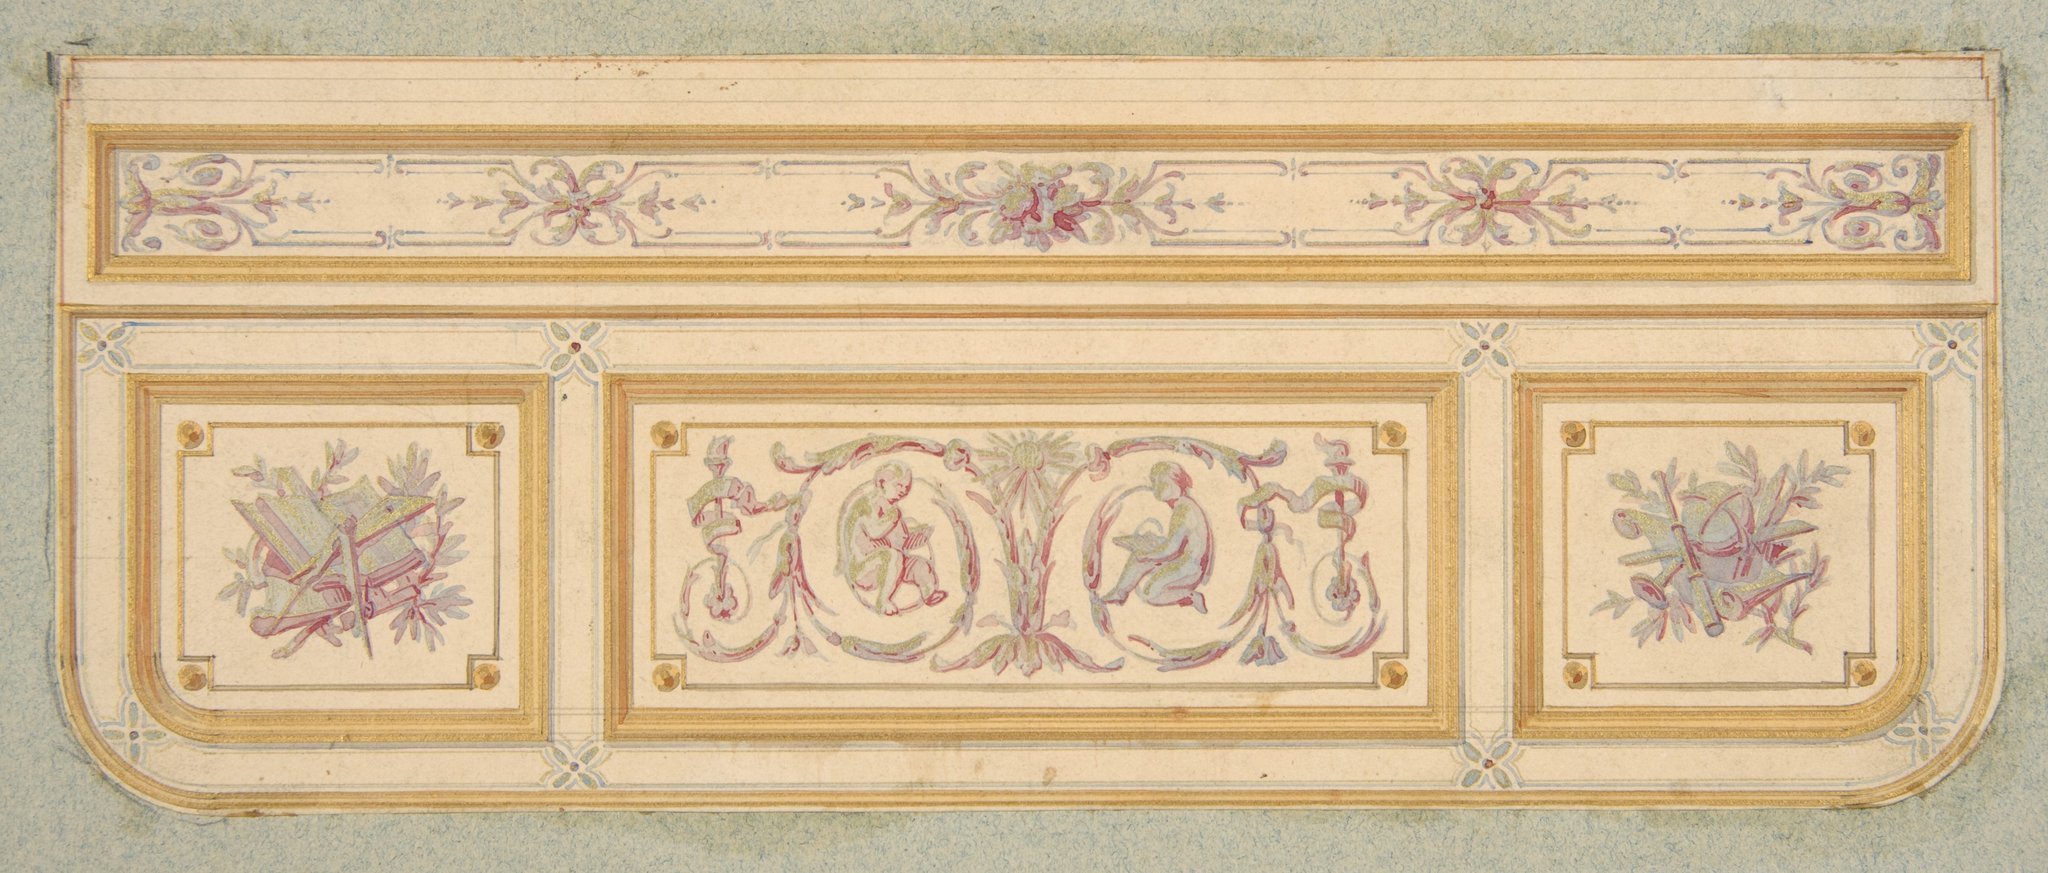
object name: drawing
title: Design for a ceiling with two putti and symbols for the arts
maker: jules-edmond-charles lachaise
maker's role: artist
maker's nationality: french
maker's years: 1897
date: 1851-1900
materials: gilt, gouache, graphite, watercolor